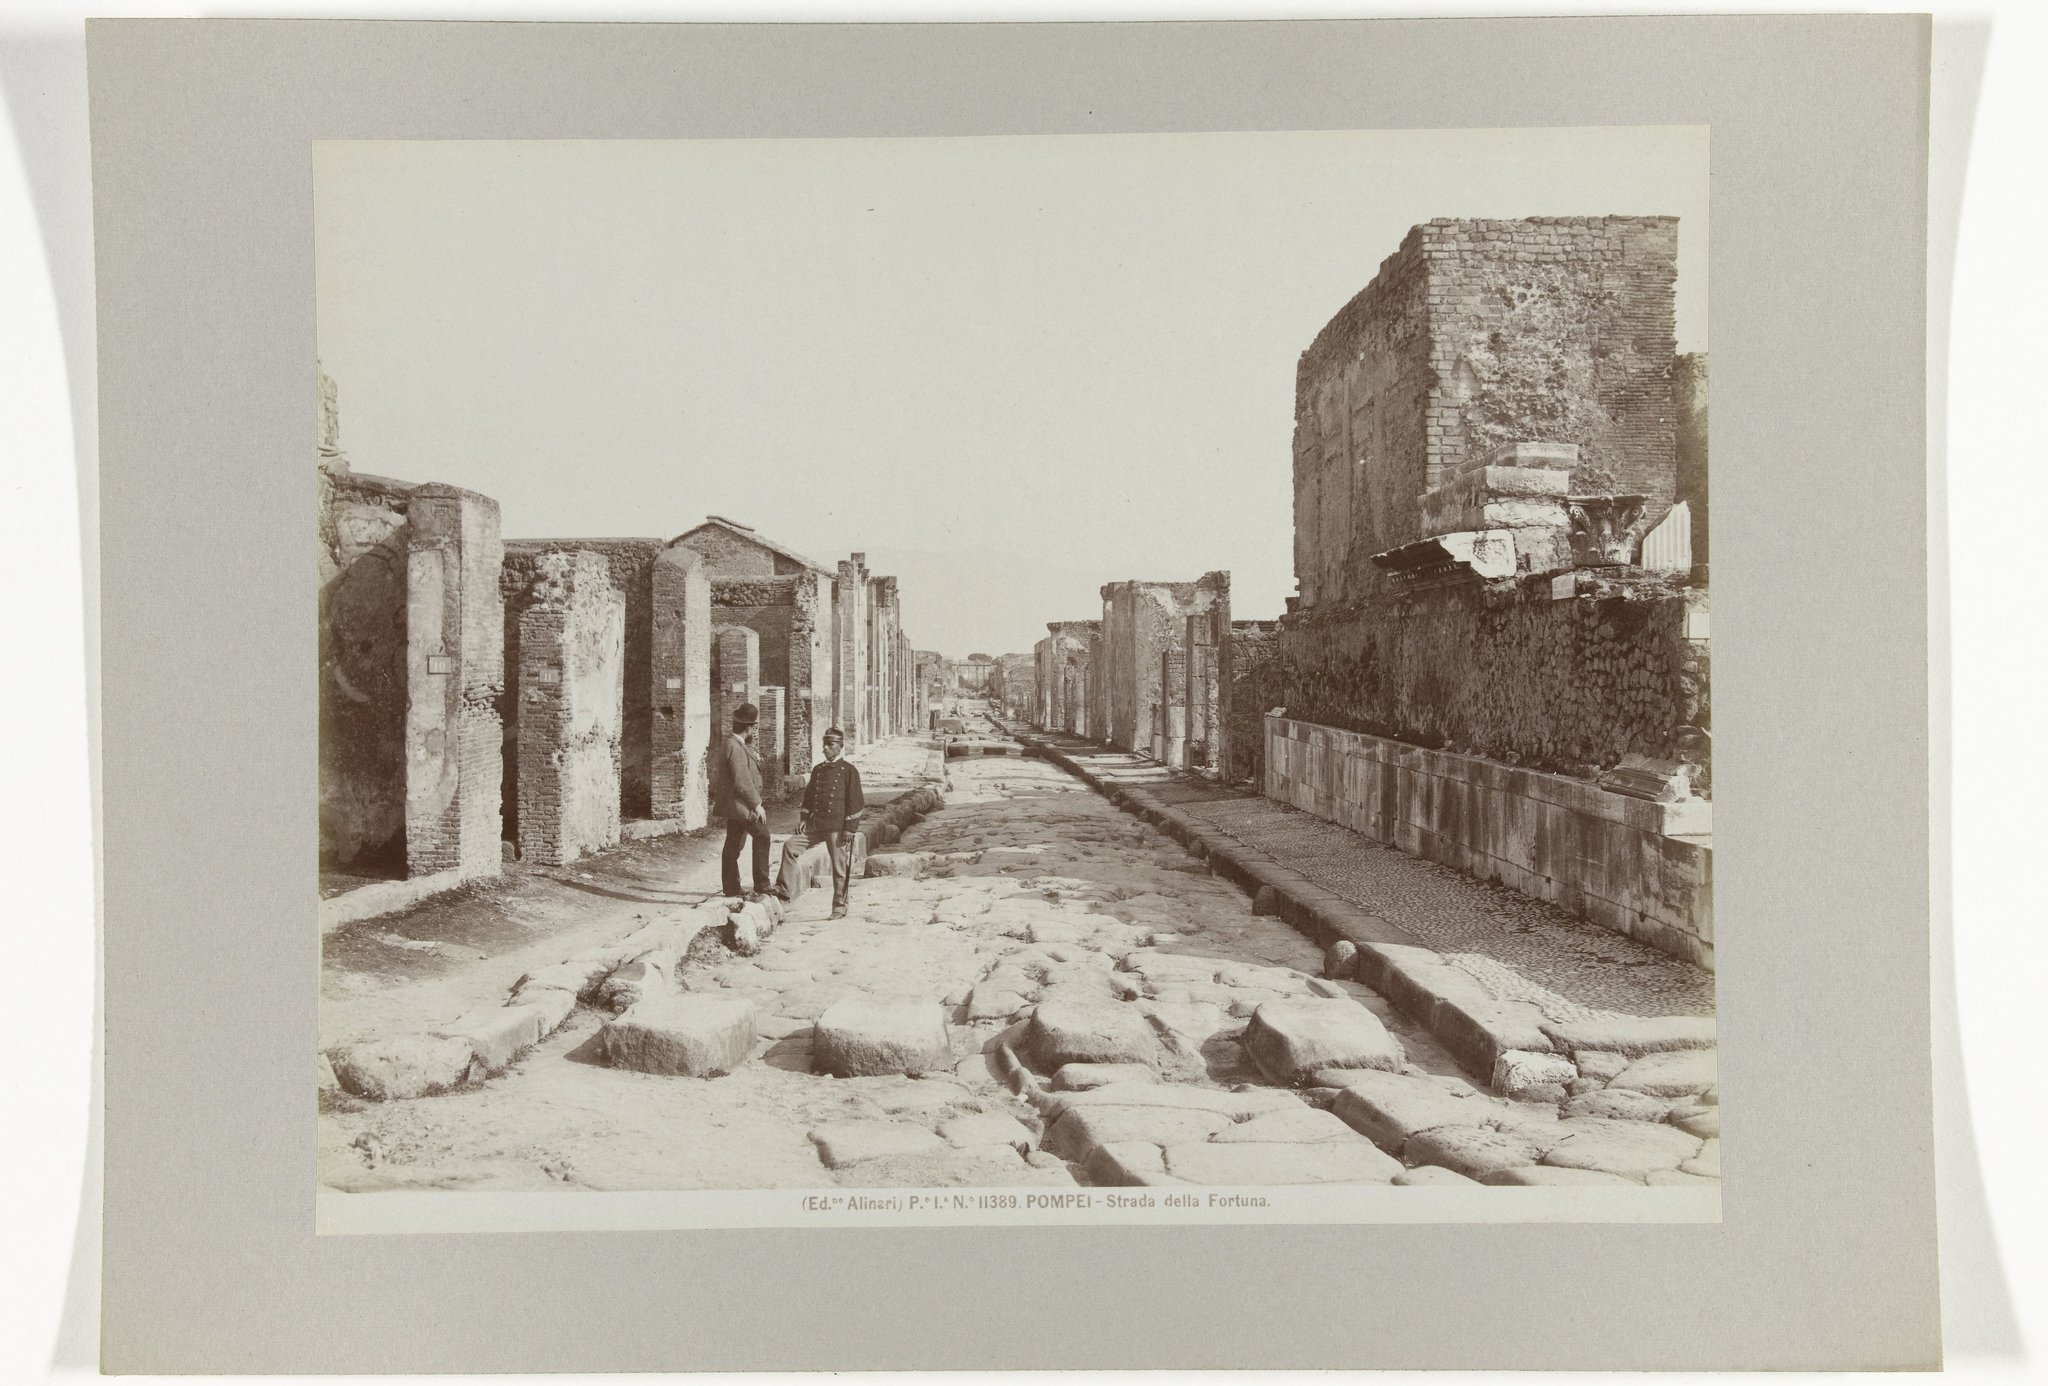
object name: photograph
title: P.e 1.a N.o 11389. POMPEI - Strada della Fortuna.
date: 1880-1895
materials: cardboard, paper, photographic support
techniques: albumen print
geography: florence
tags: square, place, circus, etc., pompeii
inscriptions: number: ‘67.’